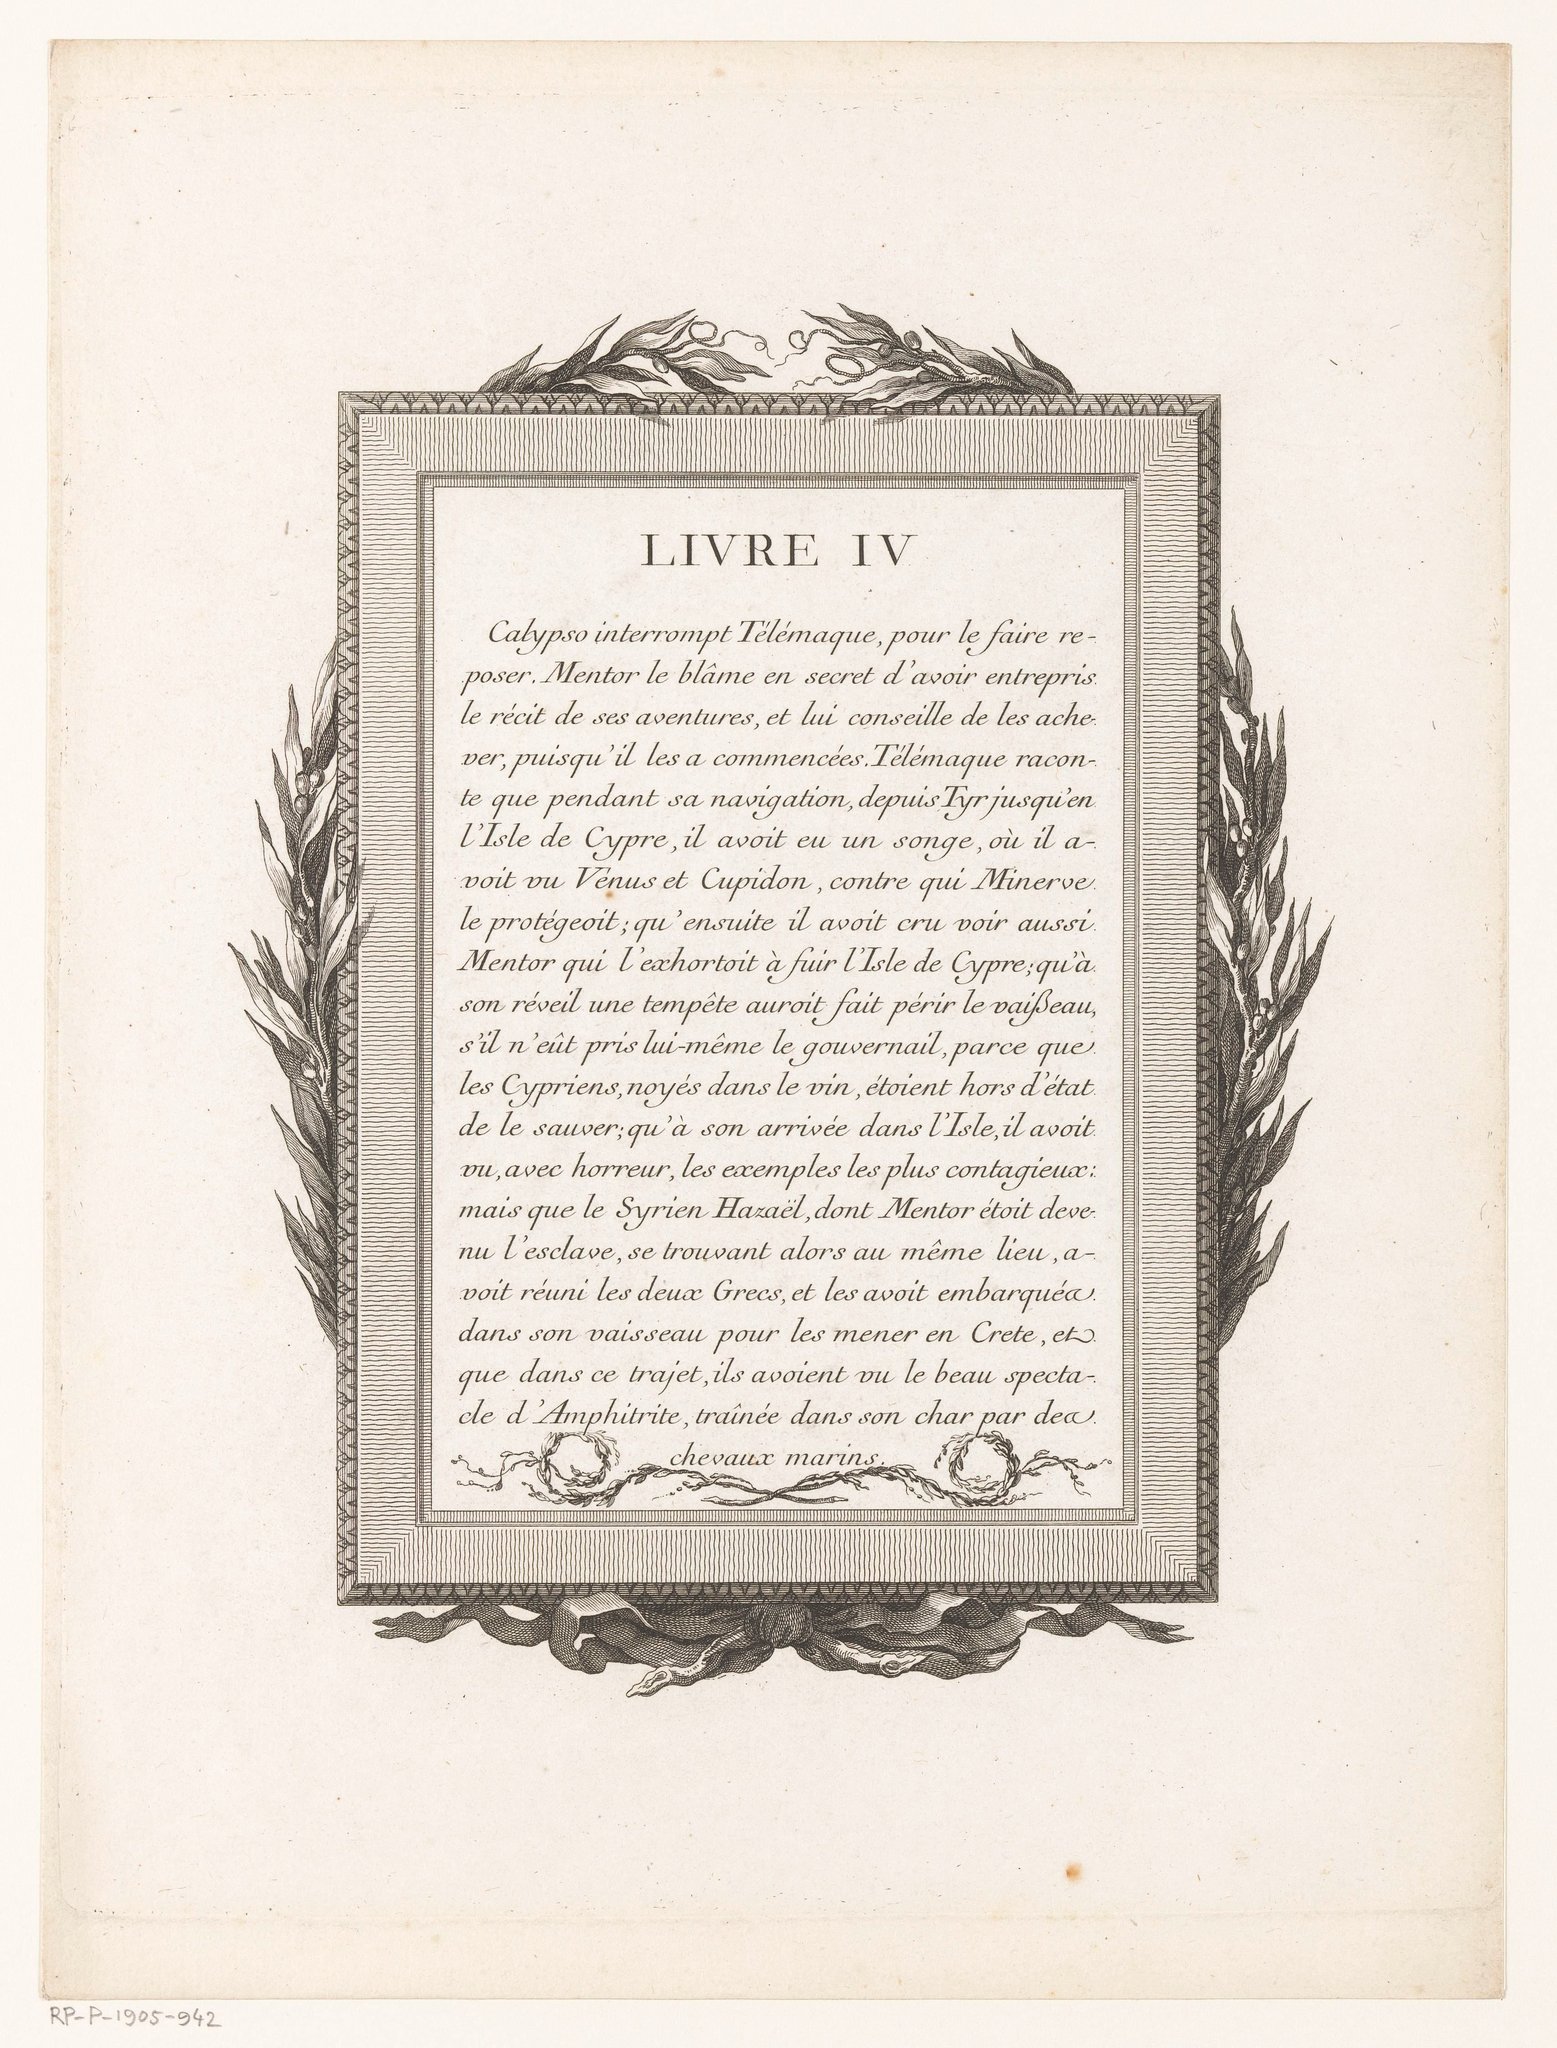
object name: book illustration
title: Omkaderde Franse tekst met olijftakken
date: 1785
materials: paper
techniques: engraving, etching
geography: paris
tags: (fenelon, telemachus) specific works of literature (with author, title), ornament ~ festoon, garland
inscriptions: collector's mark: Lugt 2228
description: Eenentwintigregelige Franse tekst, getiteld 'Livre IV'. De tekst wordt gekaderd door een sierlijst met olijftakken en onderaan een strik.